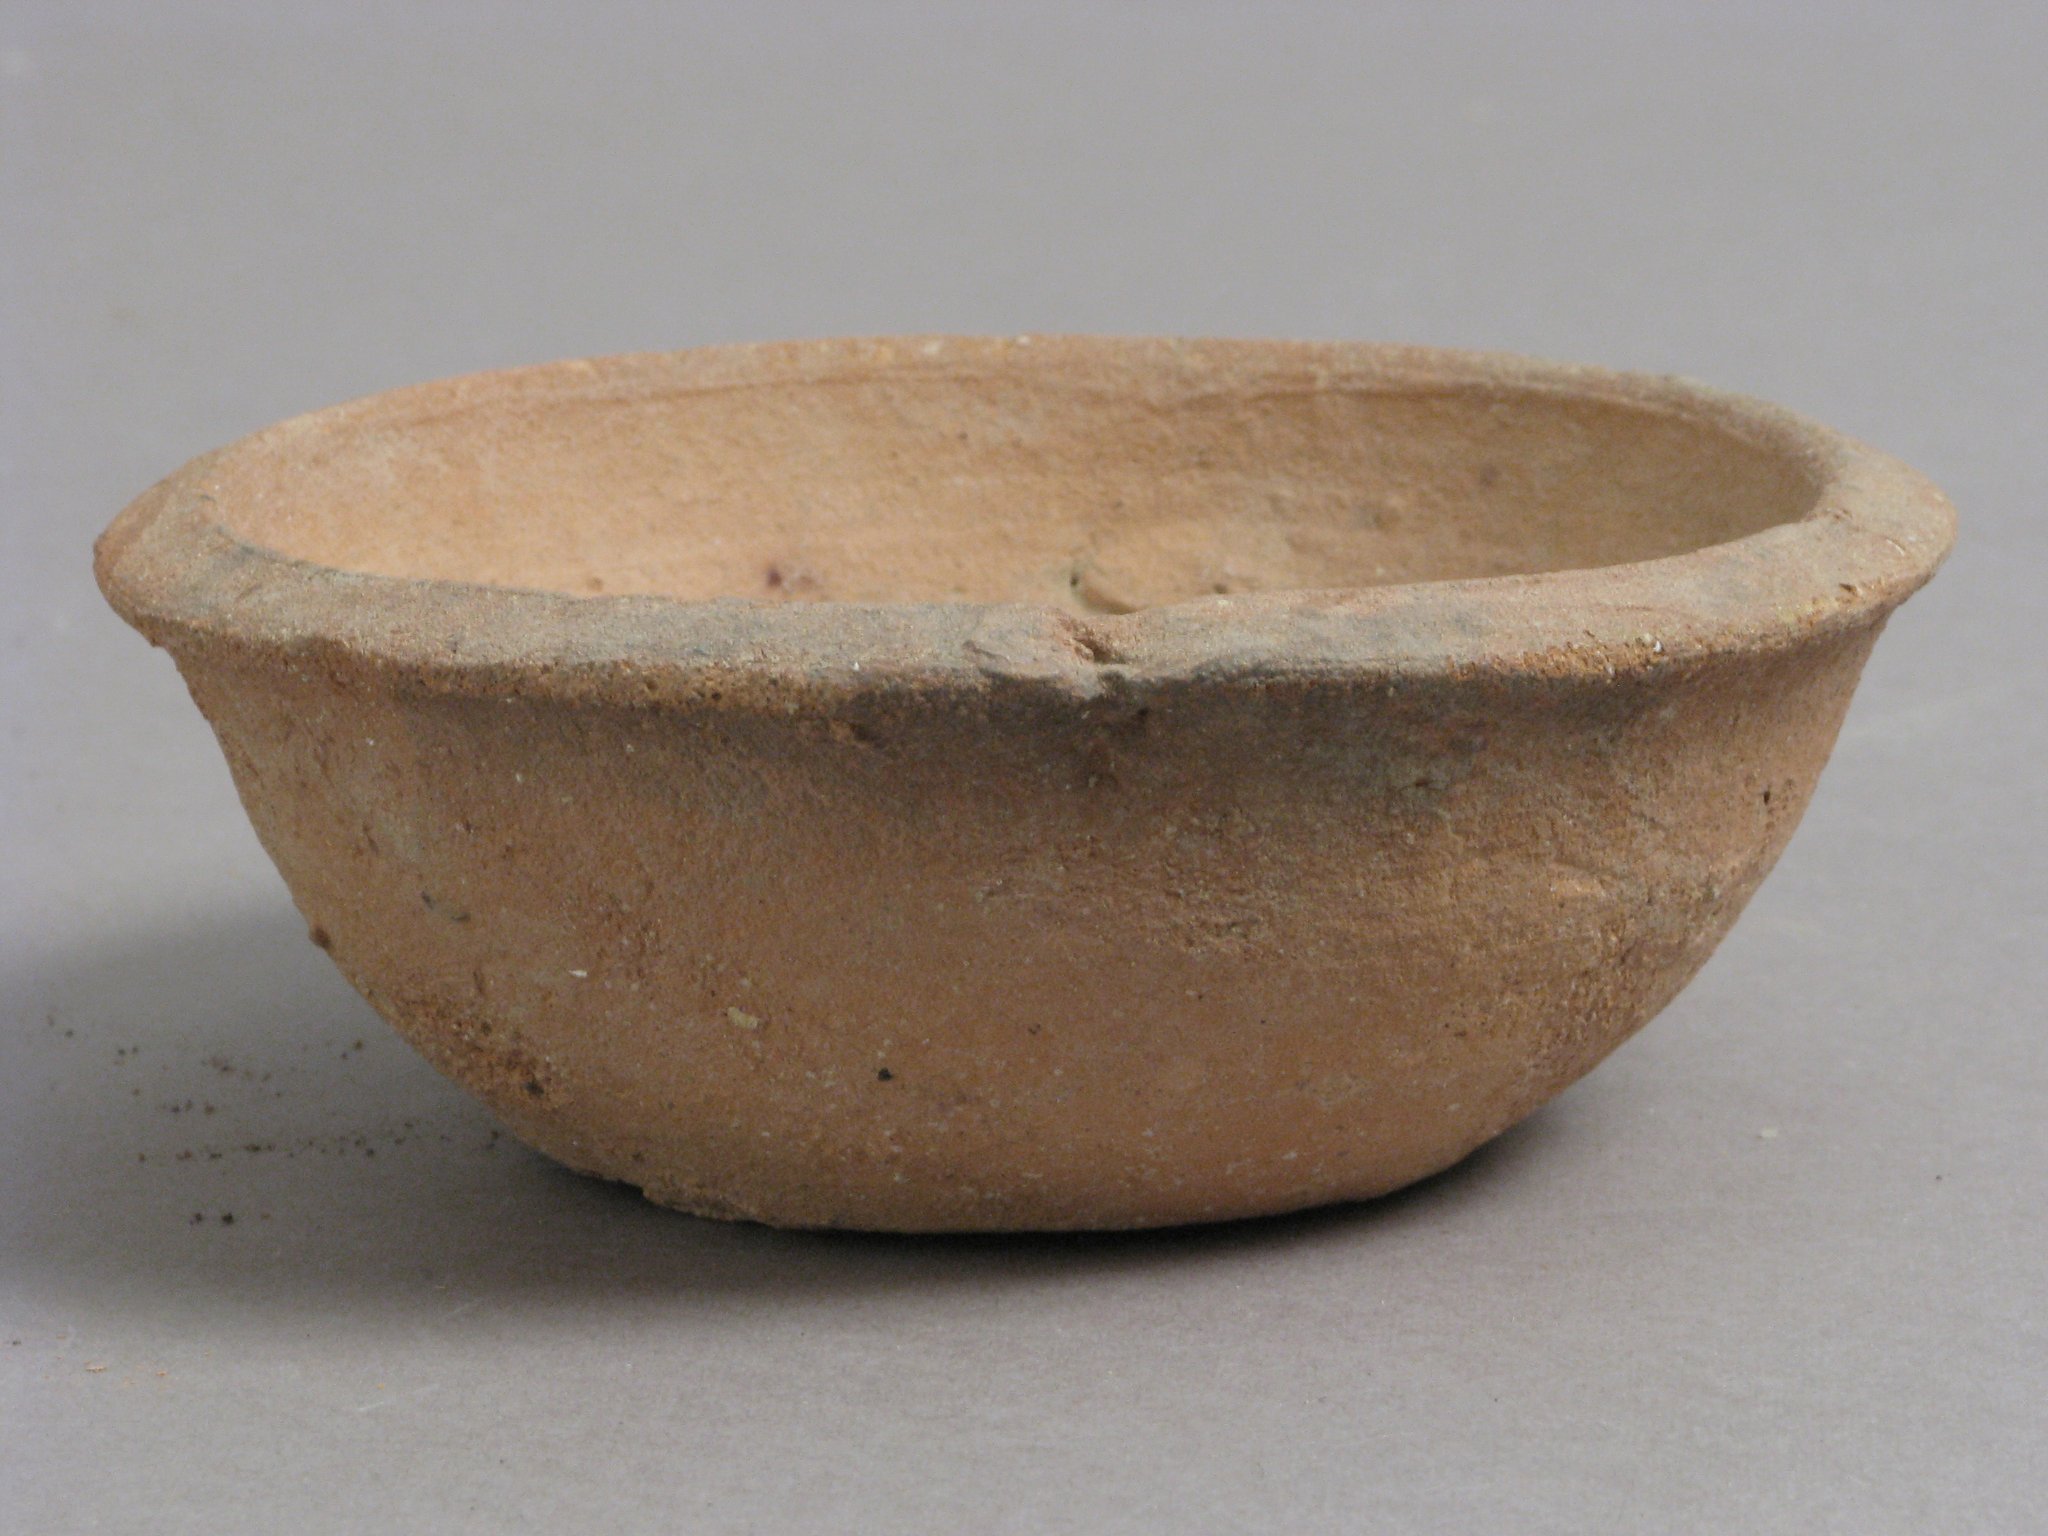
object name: bowl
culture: coptic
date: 301-700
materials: earthenware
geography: egypt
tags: bowls